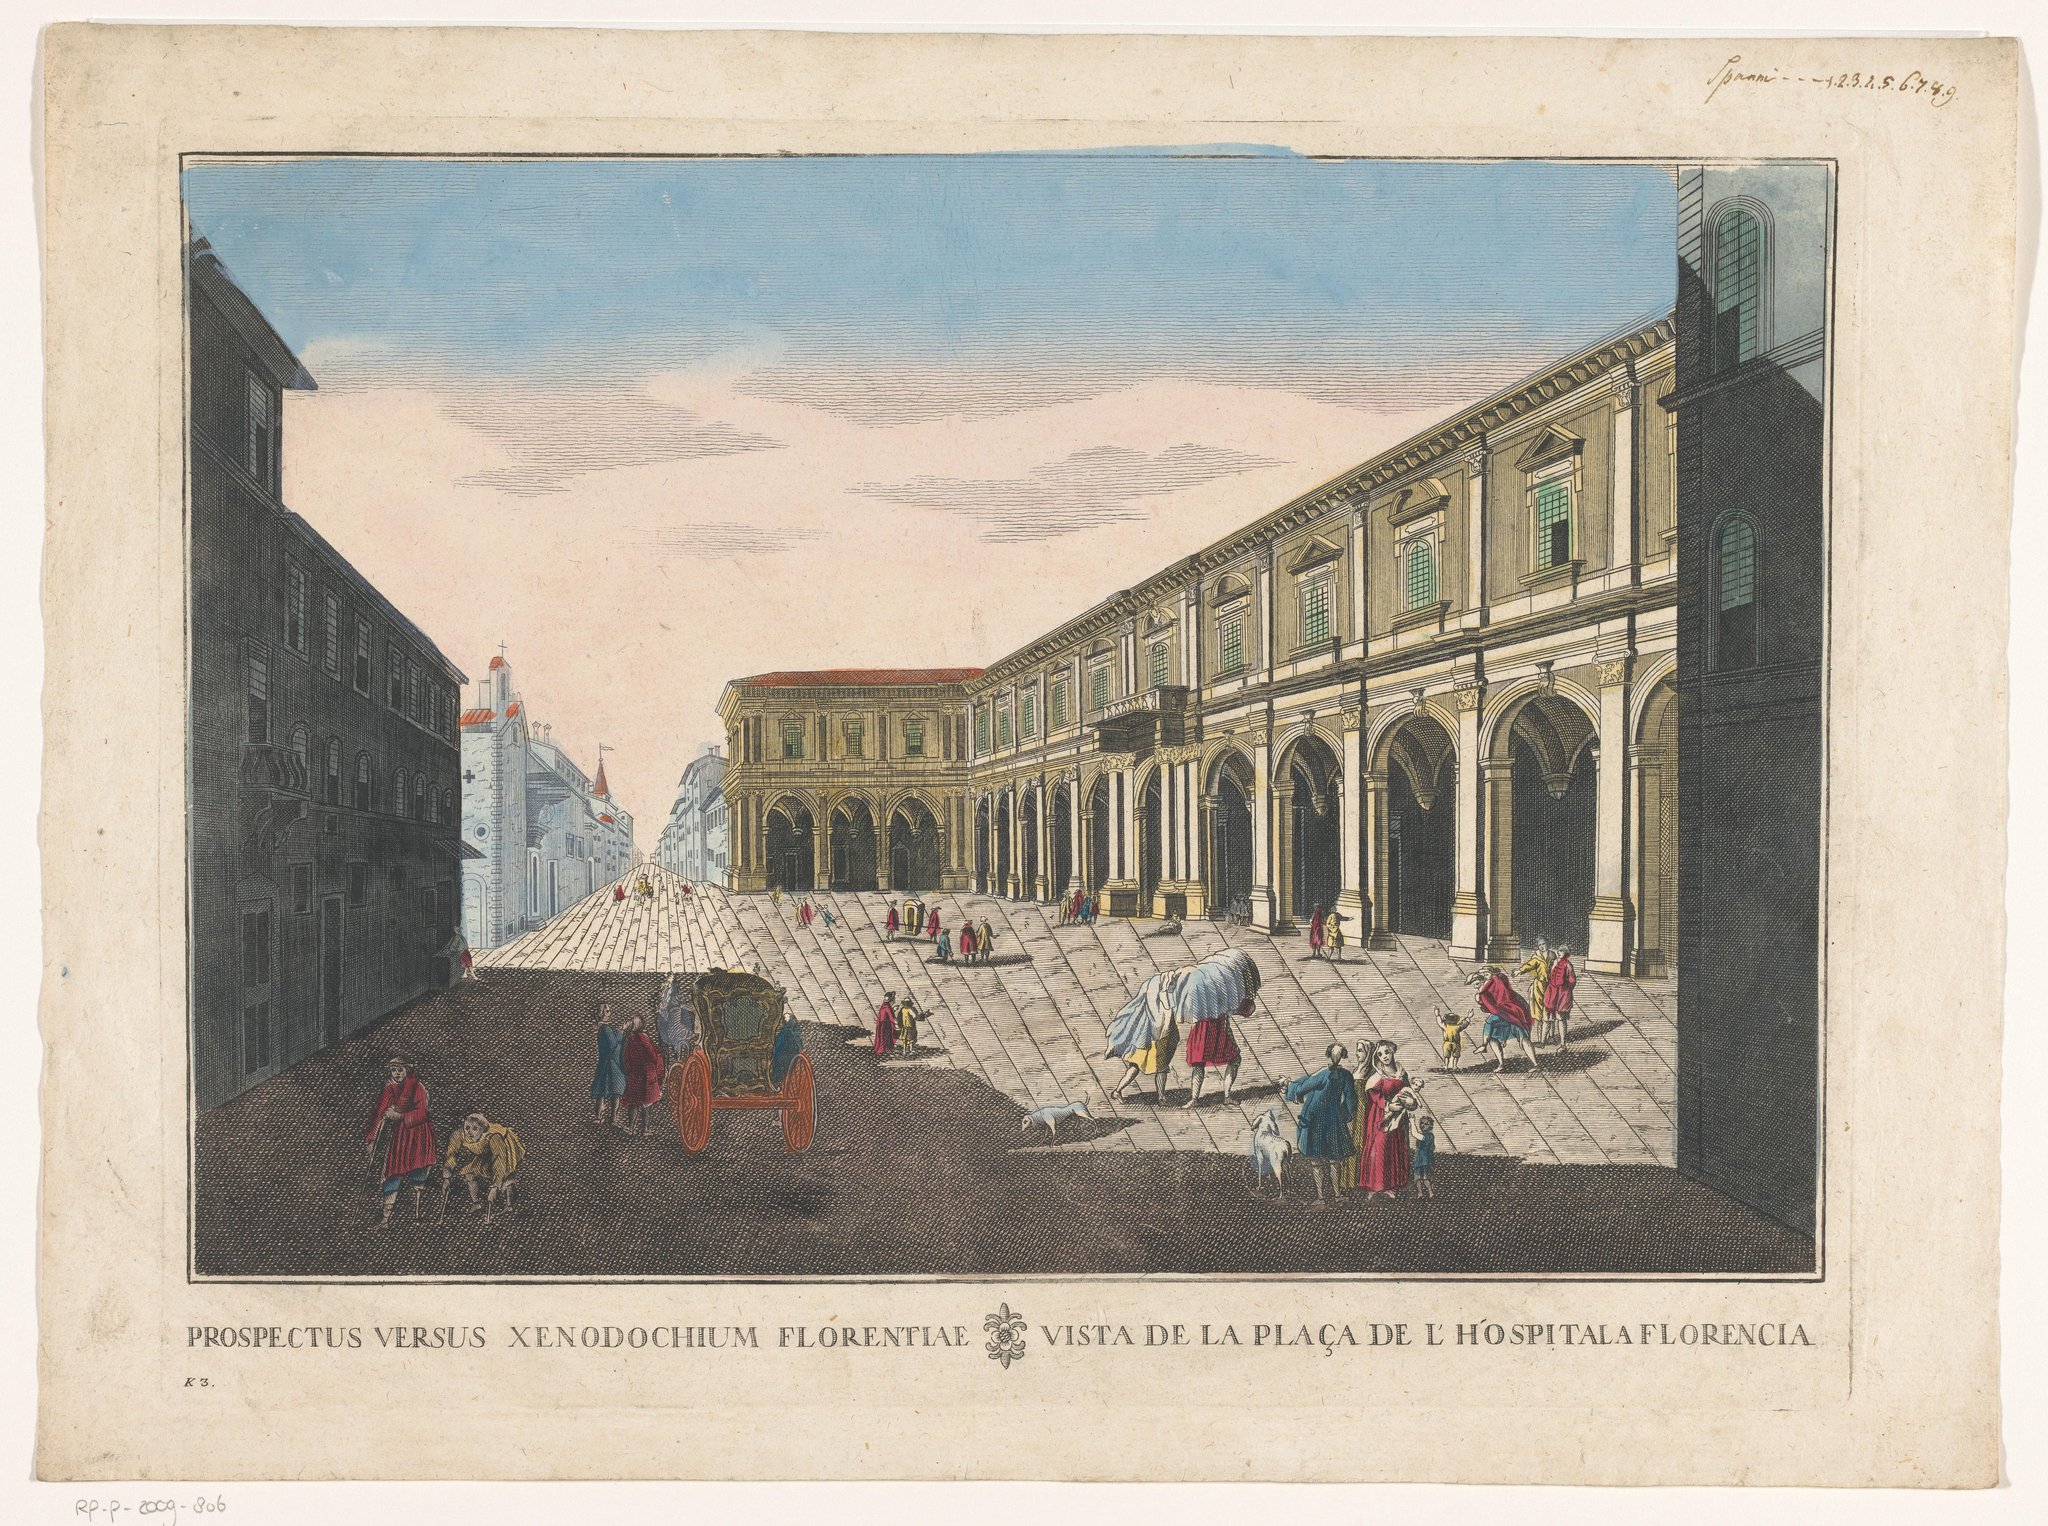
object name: opticaprent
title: Prospectus versus Xenodochium Florentiae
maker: Anonymous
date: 1700-1799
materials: paper, watercolor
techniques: brush, etching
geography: italy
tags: ospedale di santa maria nuova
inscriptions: collector's mark: Lugt 2228